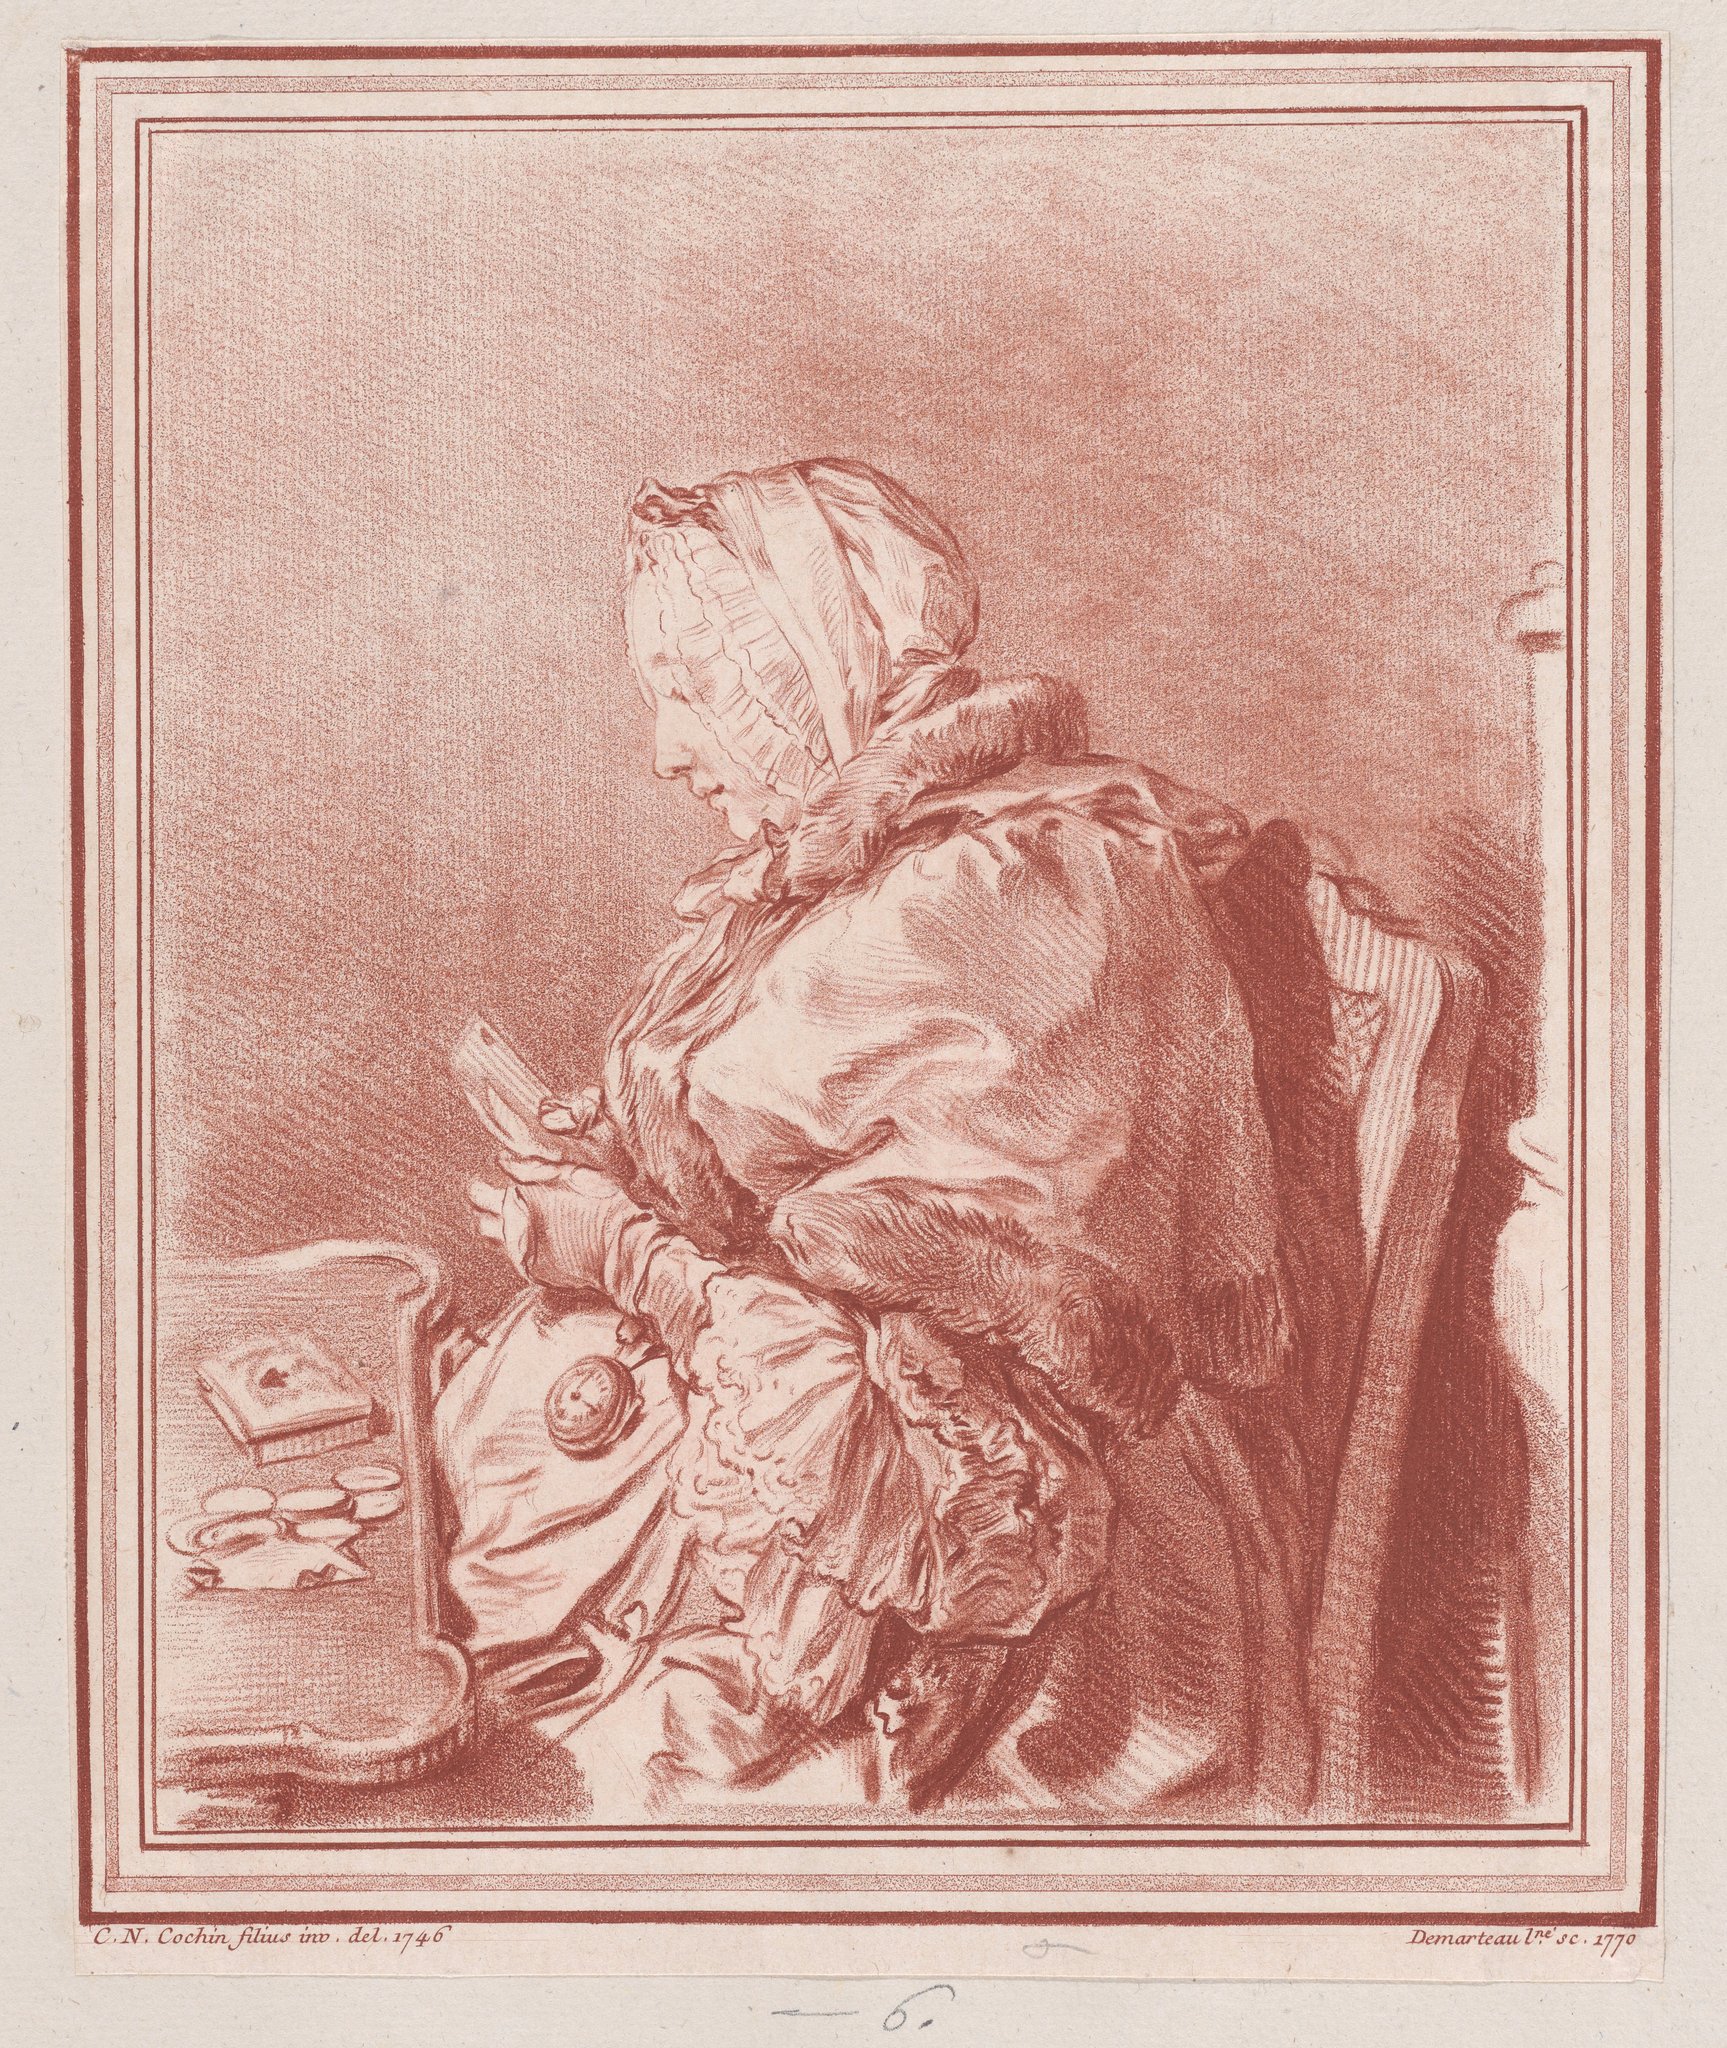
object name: print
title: Woman playing cards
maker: gilles demarteau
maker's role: artist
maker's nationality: french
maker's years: 1722-1776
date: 1770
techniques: printmaking, etching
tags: women,playing cards,games